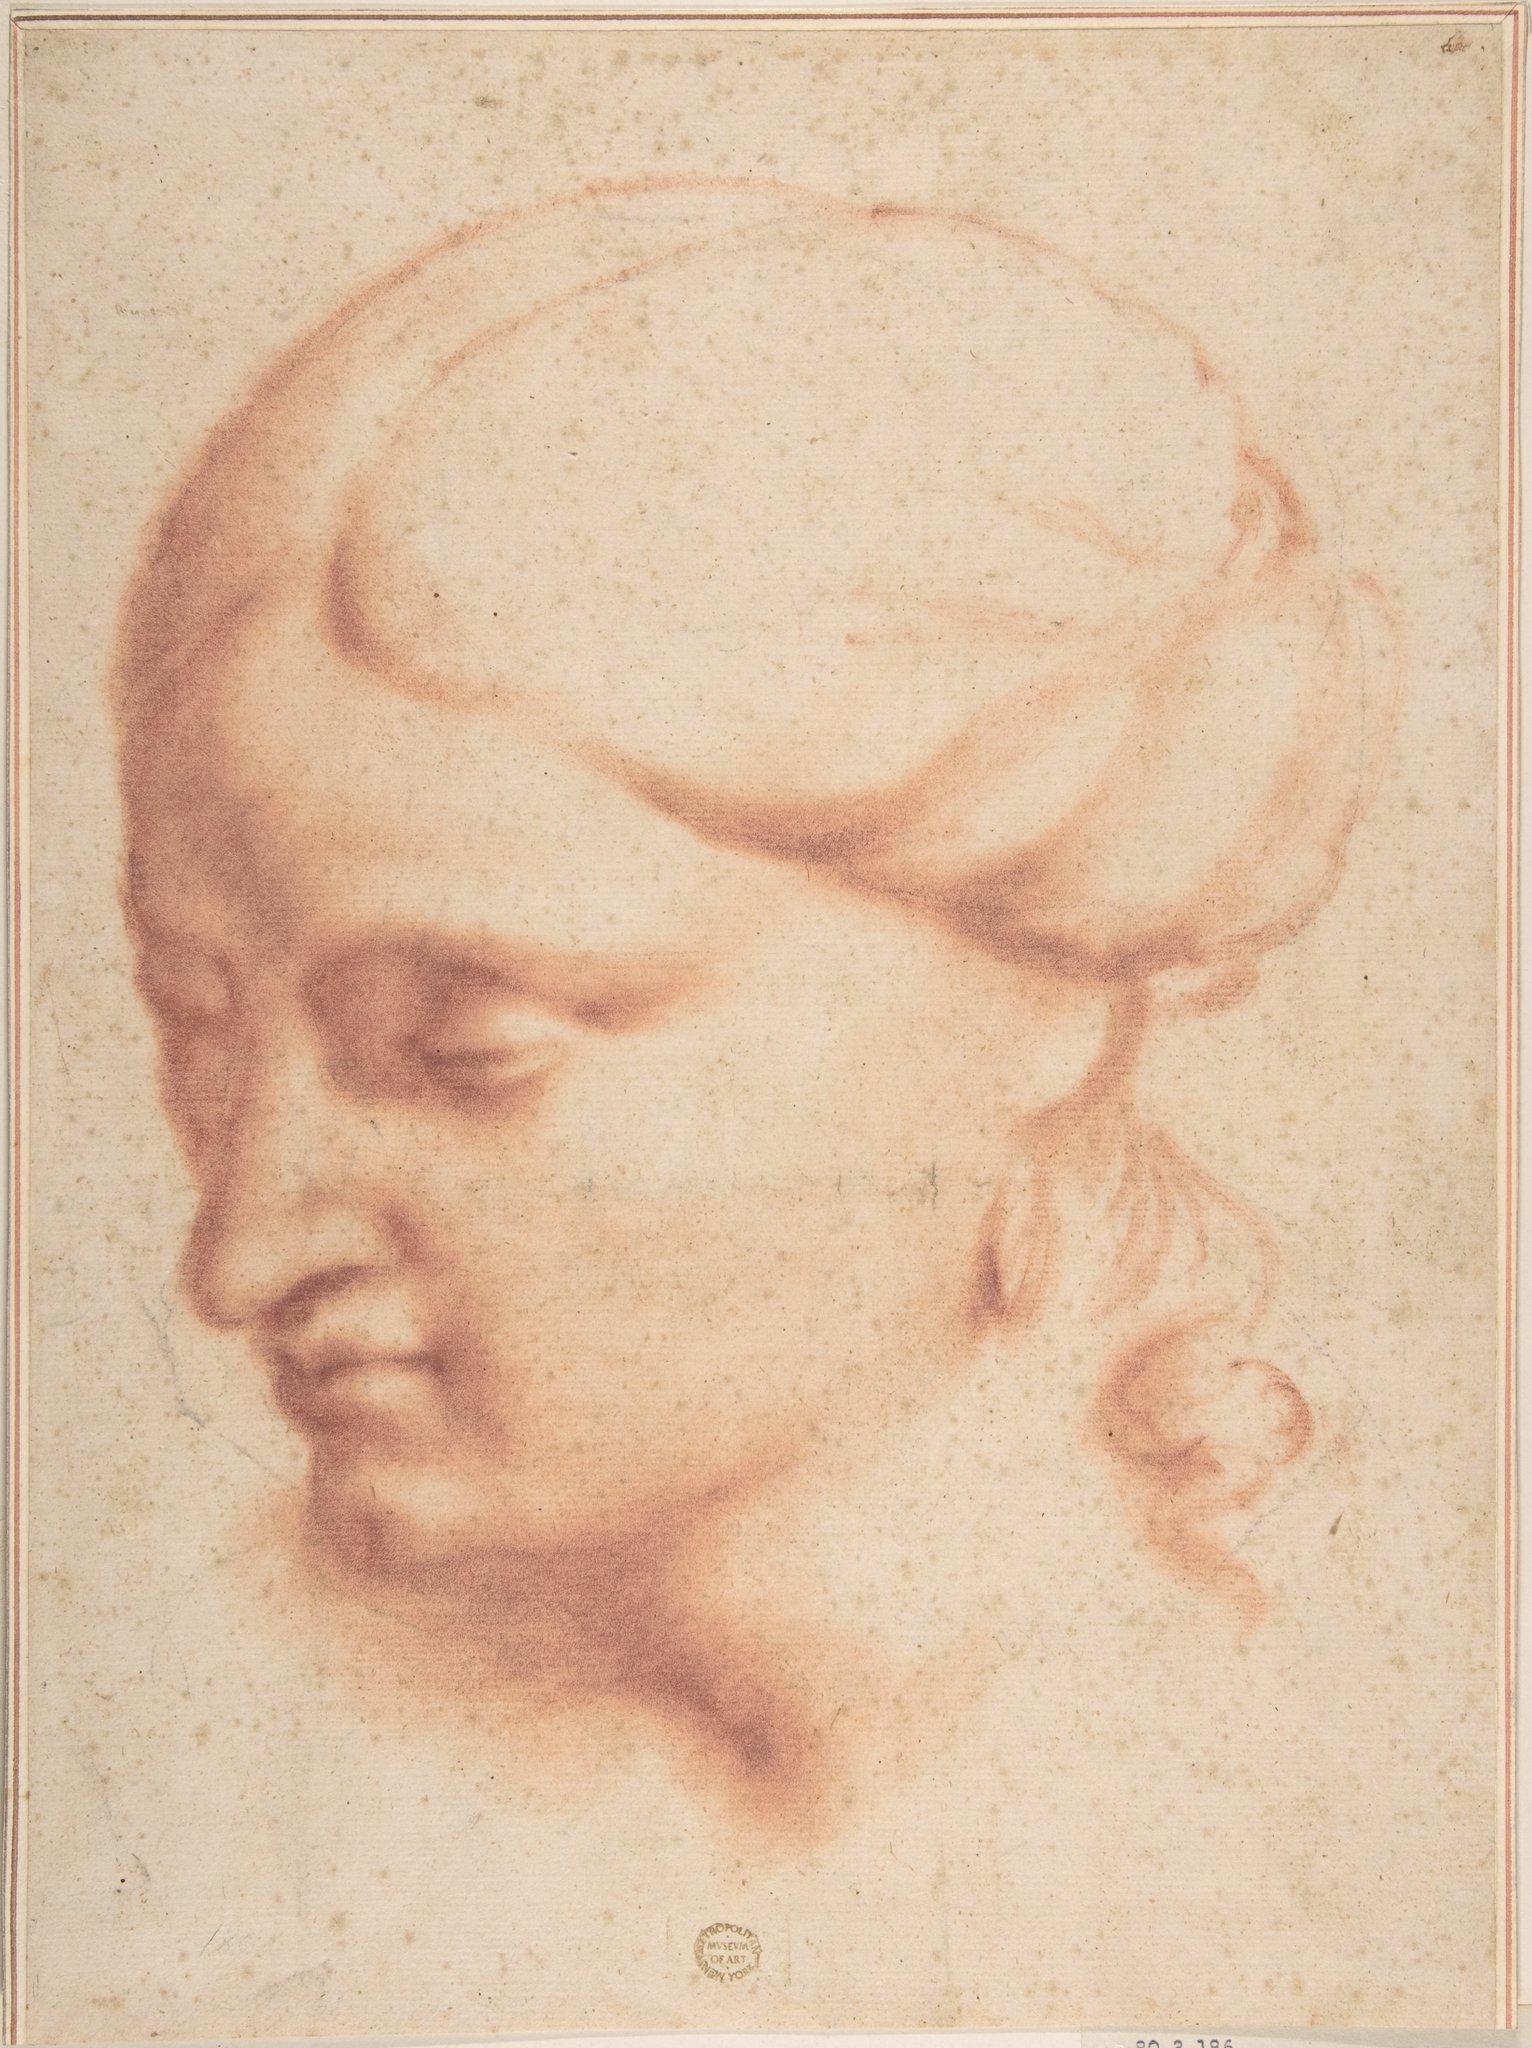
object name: drawing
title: Head of a Woman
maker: anonymous, italian, roman-bolognese, 17th century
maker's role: artist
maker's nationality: italian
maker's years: 1600-1700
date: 1601-1700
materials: chalk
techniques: printmaking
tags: heads,portraits,women